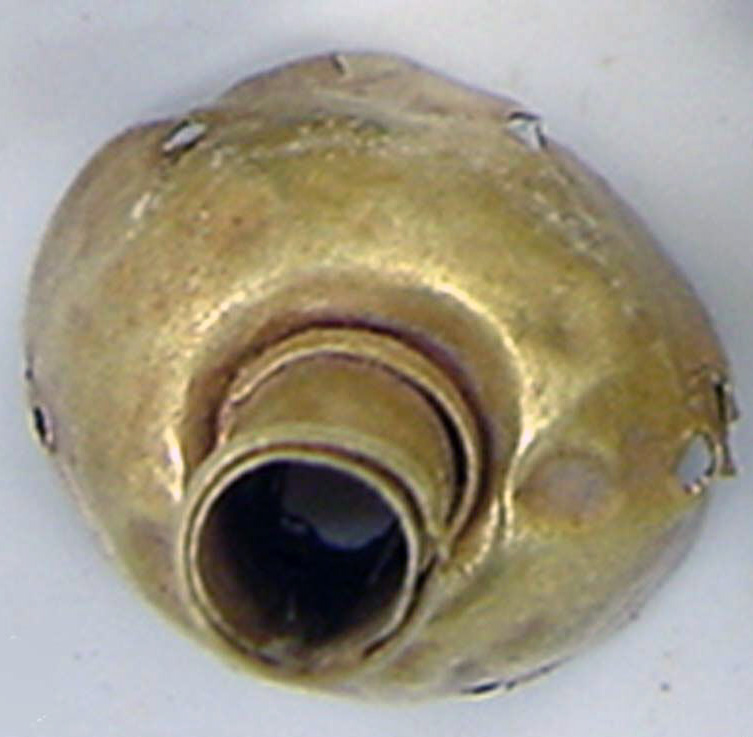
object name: plaque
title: Flower-Shaped Plaque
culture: northwest chinese or eastern central asian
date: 634-900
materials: gold